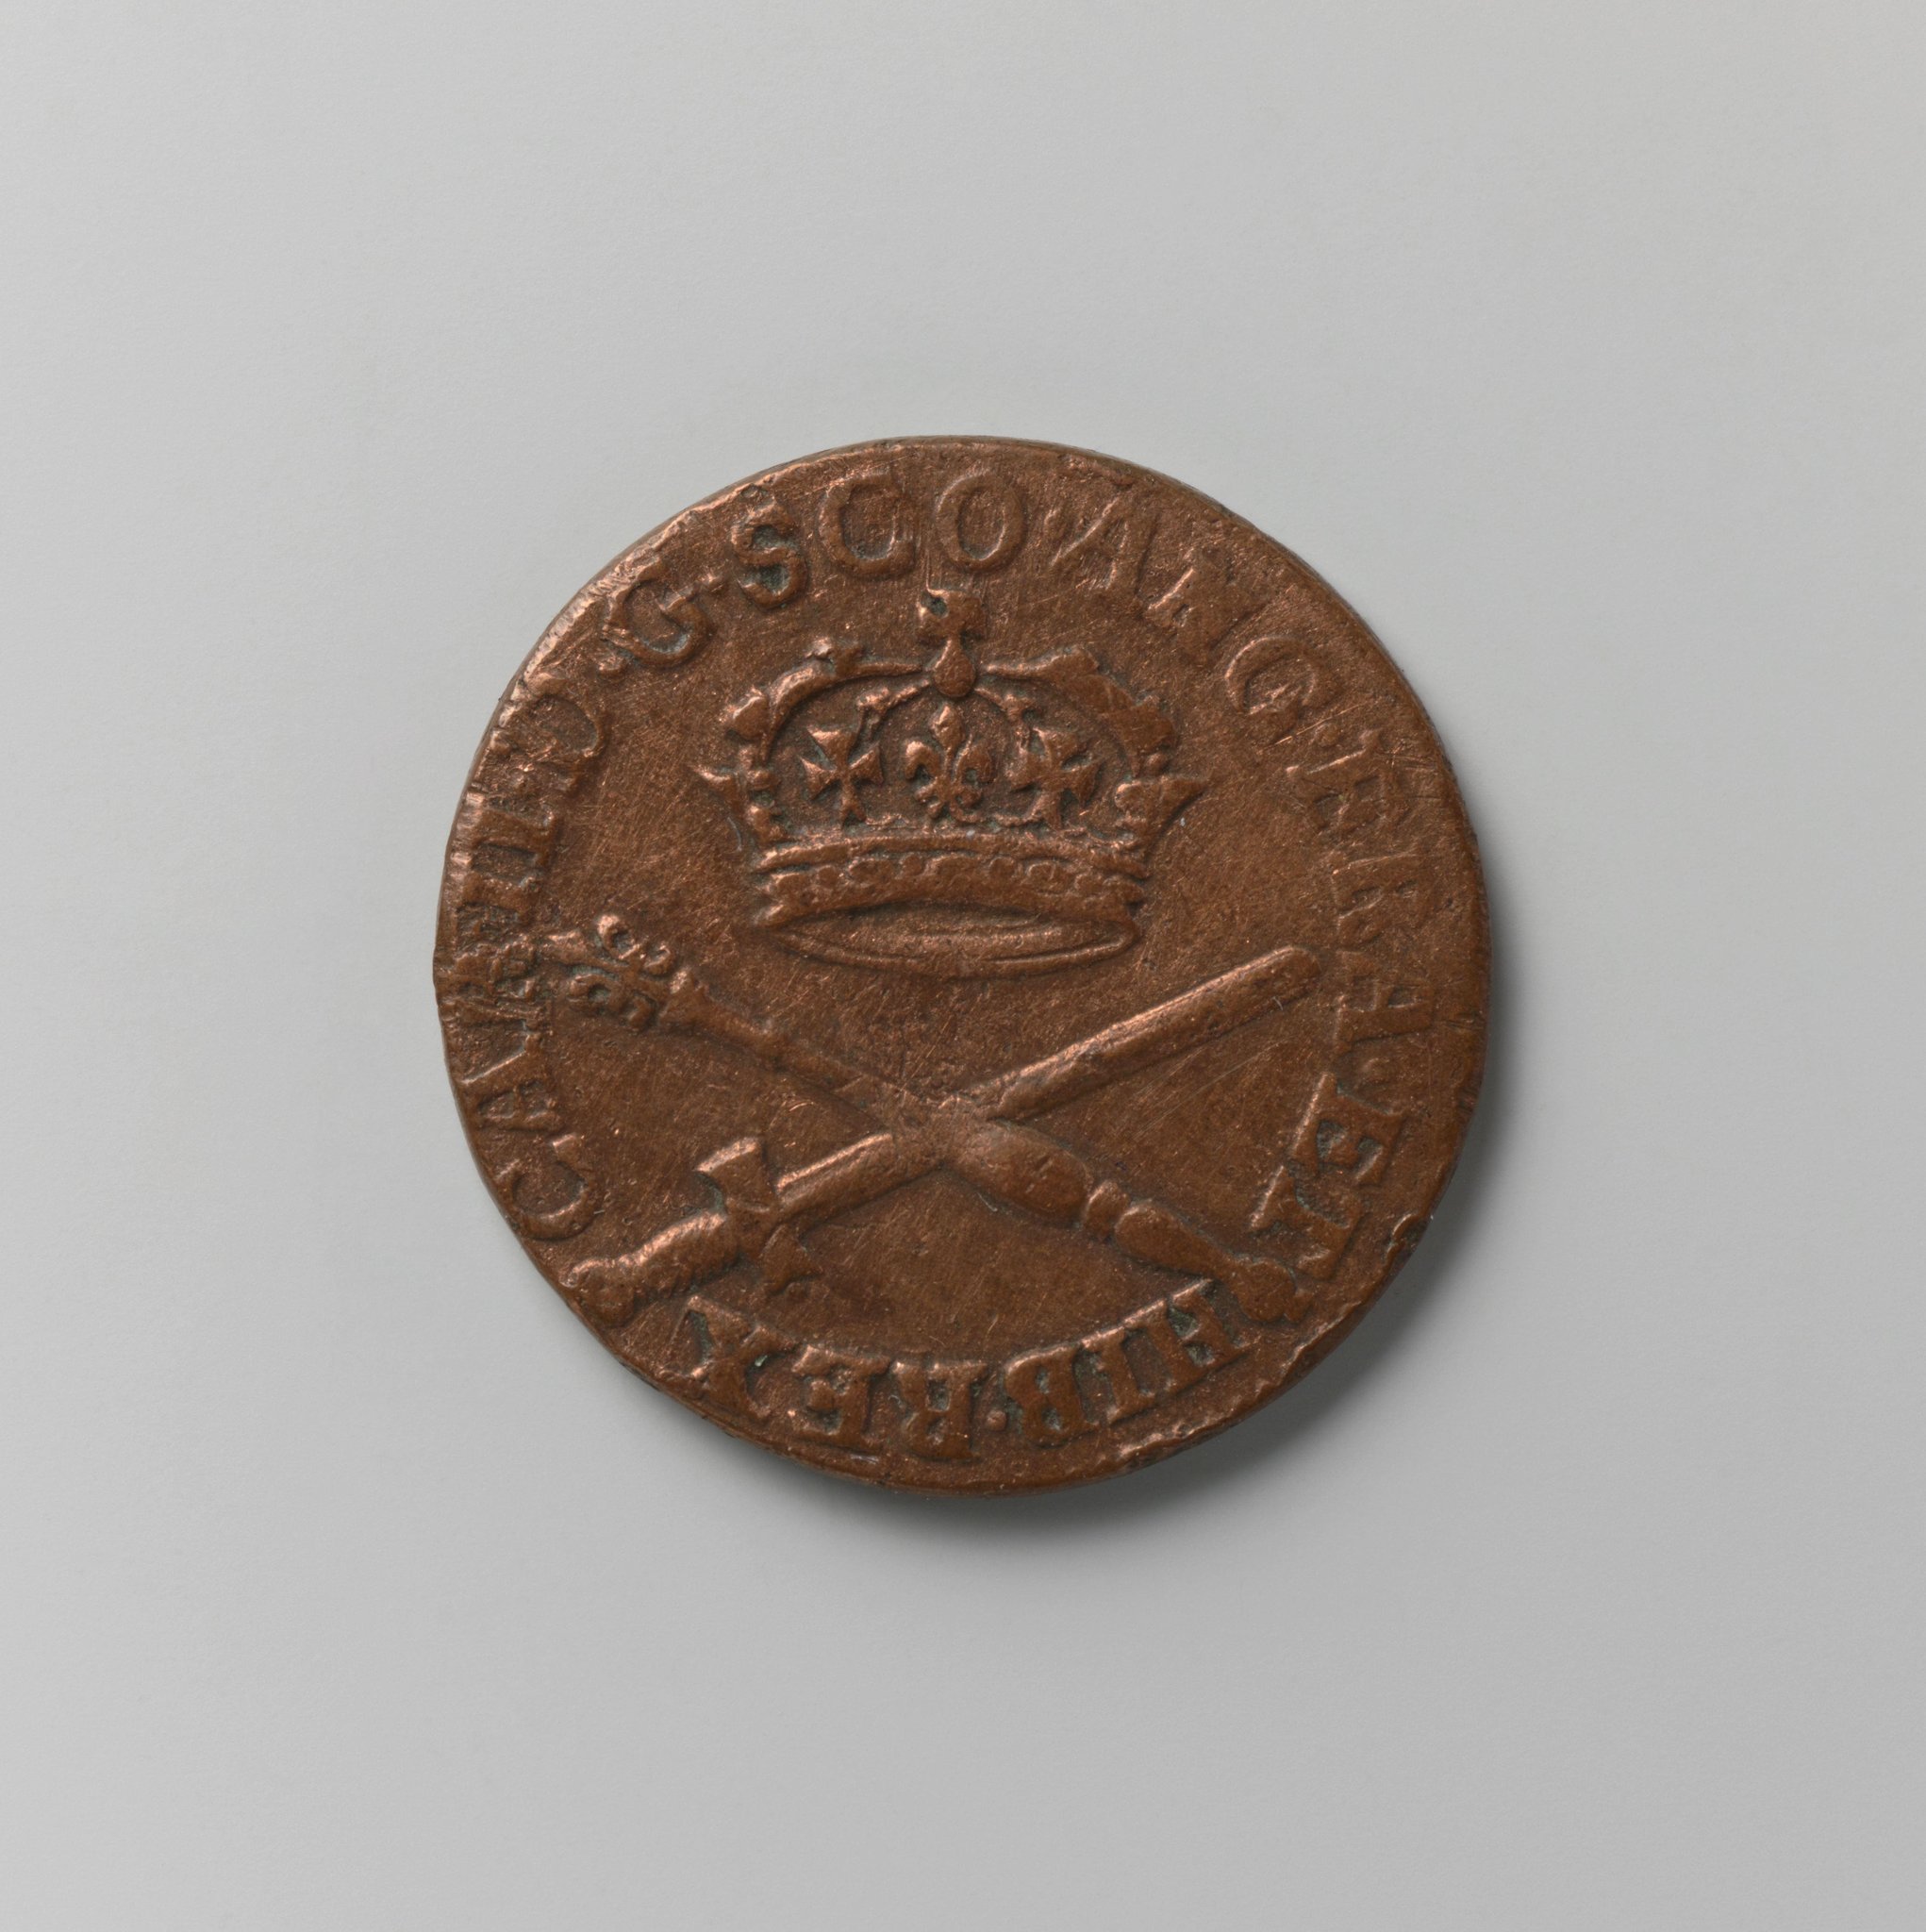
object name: coin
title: Bodle van 2 pence scotch uit Schotland van Karel II, 1677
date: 1677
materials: copper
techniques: striking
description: Koperen munt. Voorzijde: gekruist zwaard en scepter. Daarboven kroon. Keerzijde: distel-plant, waarboven jaartal in omschrift.